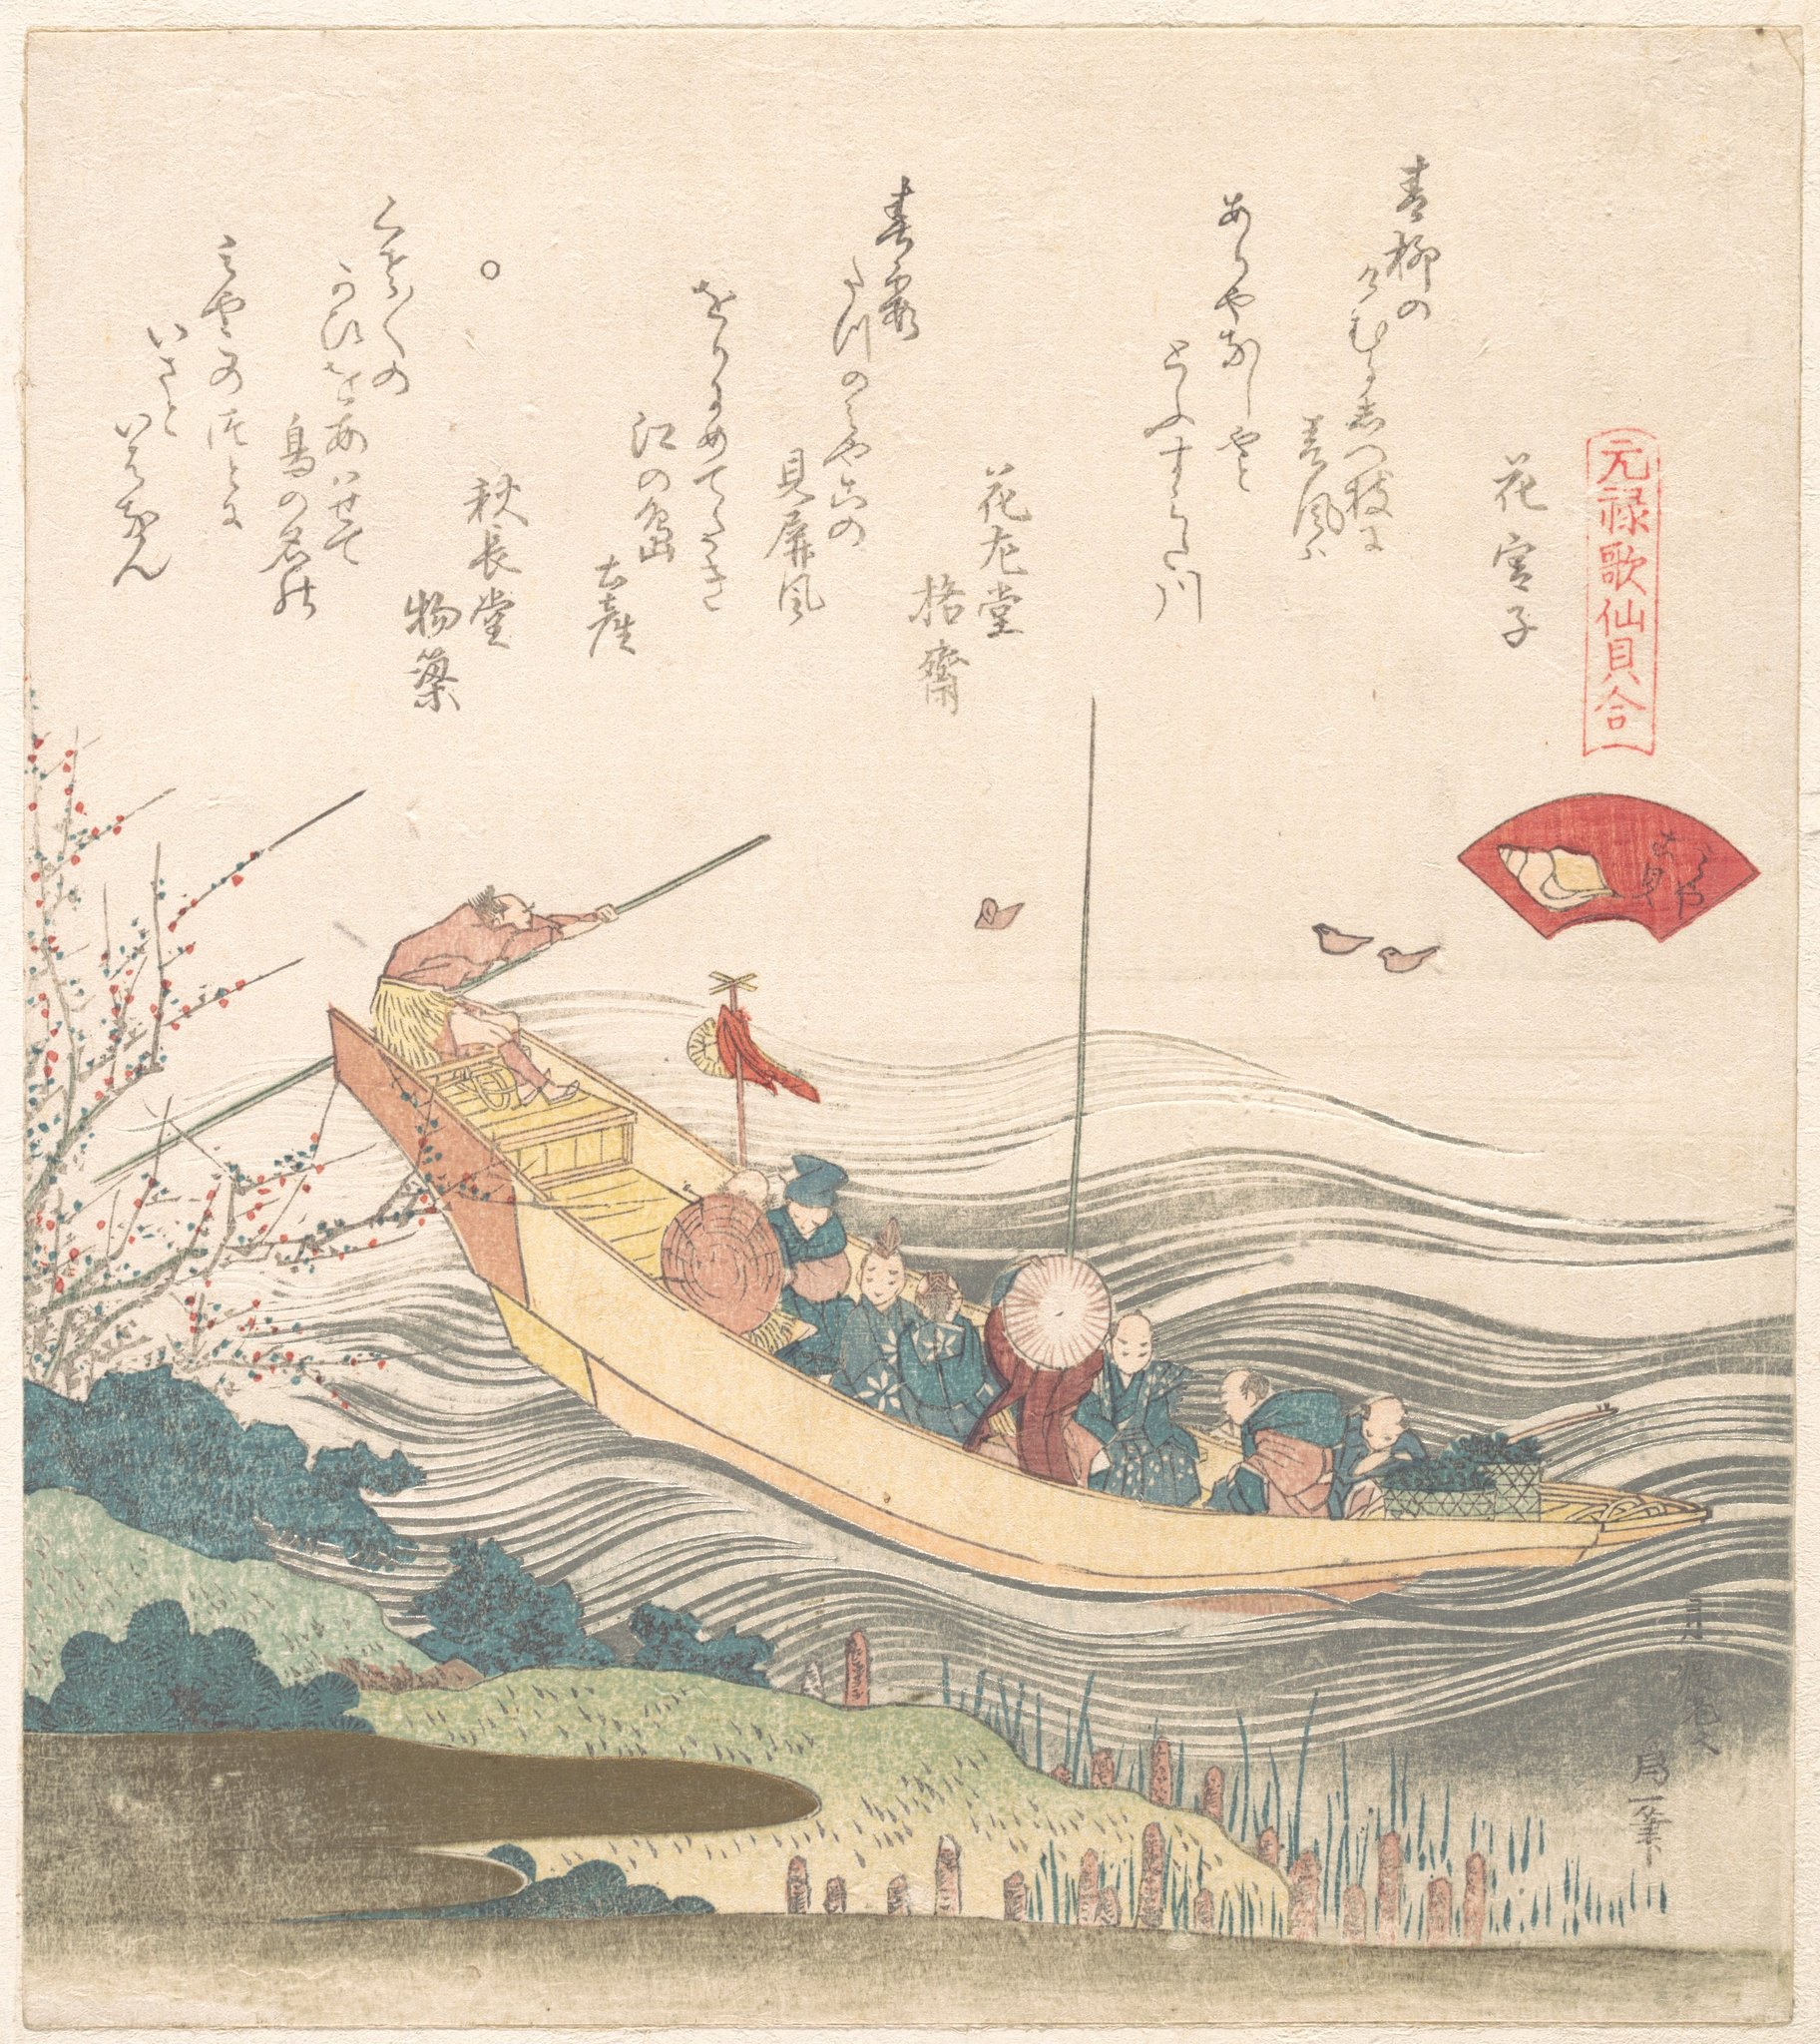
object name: print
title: Miyako Shell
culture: japanese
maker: katsushika hokusai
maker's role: artist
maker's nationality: japanese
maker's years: 1760-1849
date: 1821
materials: ink, paper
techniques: surimono, woodblock print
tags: men,rivers,boats